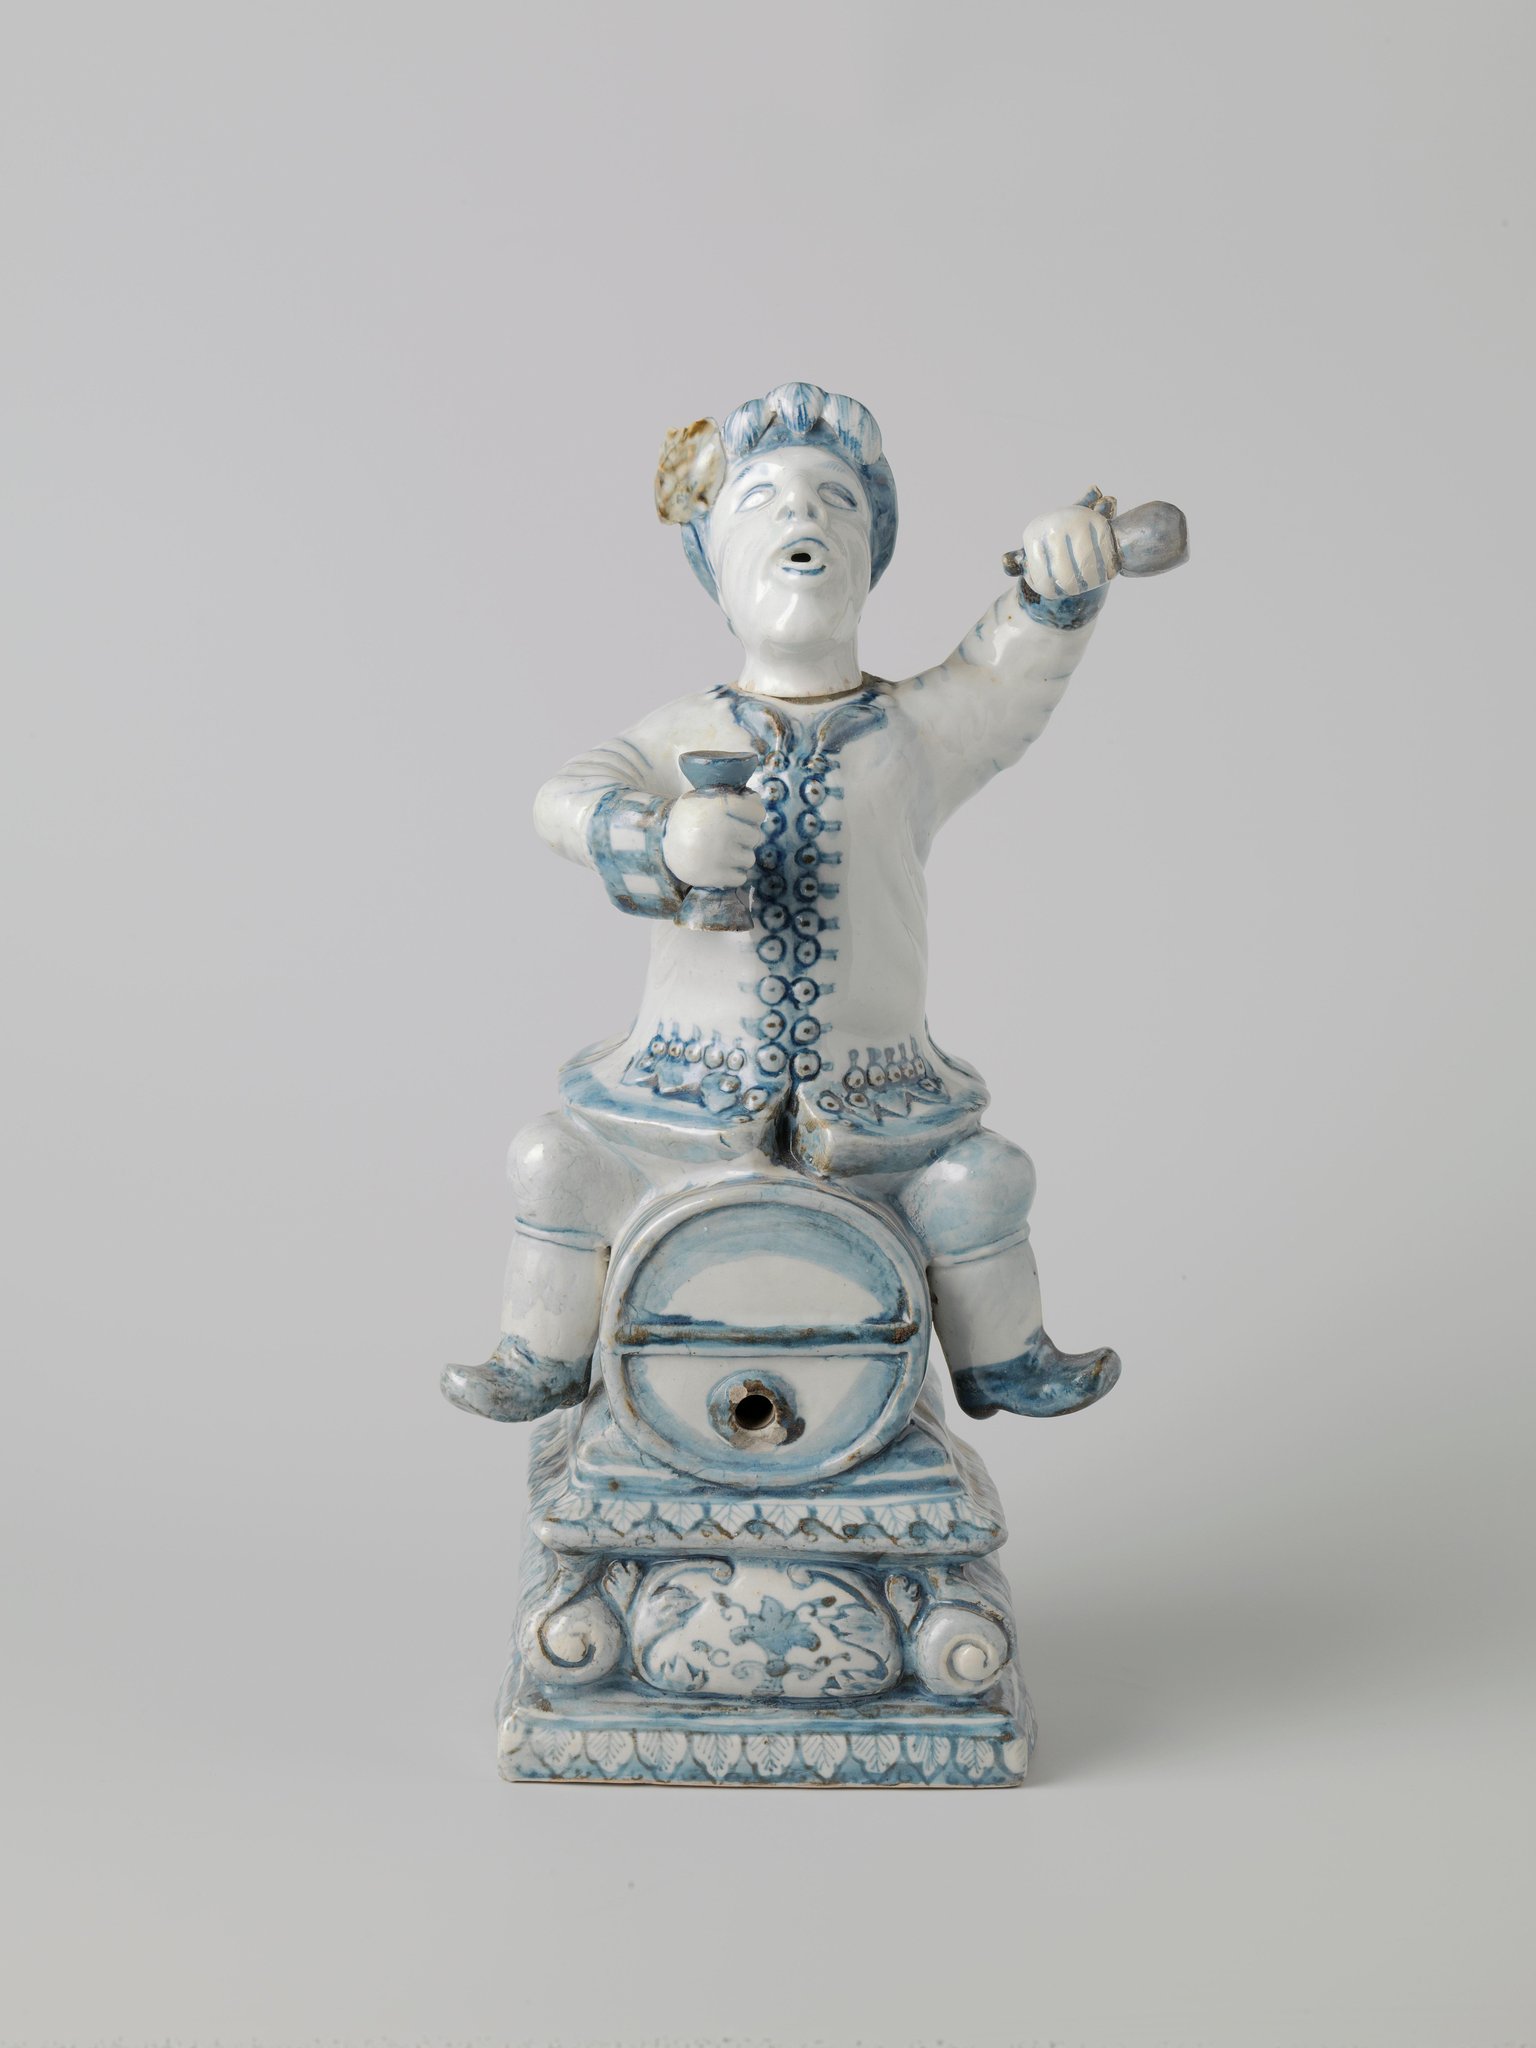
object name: cap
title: Spirit keg in the shape of a Dutchman sitting astride a barrel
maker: Anonymous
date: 1750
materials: cobalt, glaze, paint, porcelain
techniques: firing, forming, vitrification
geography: japan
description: Dop in de vorm van een hoofd voor jeneverkruik van porselein, beschilderd in onderglazuur blauw. Op het hoofd een geveerde hoed. Blauw-wit.